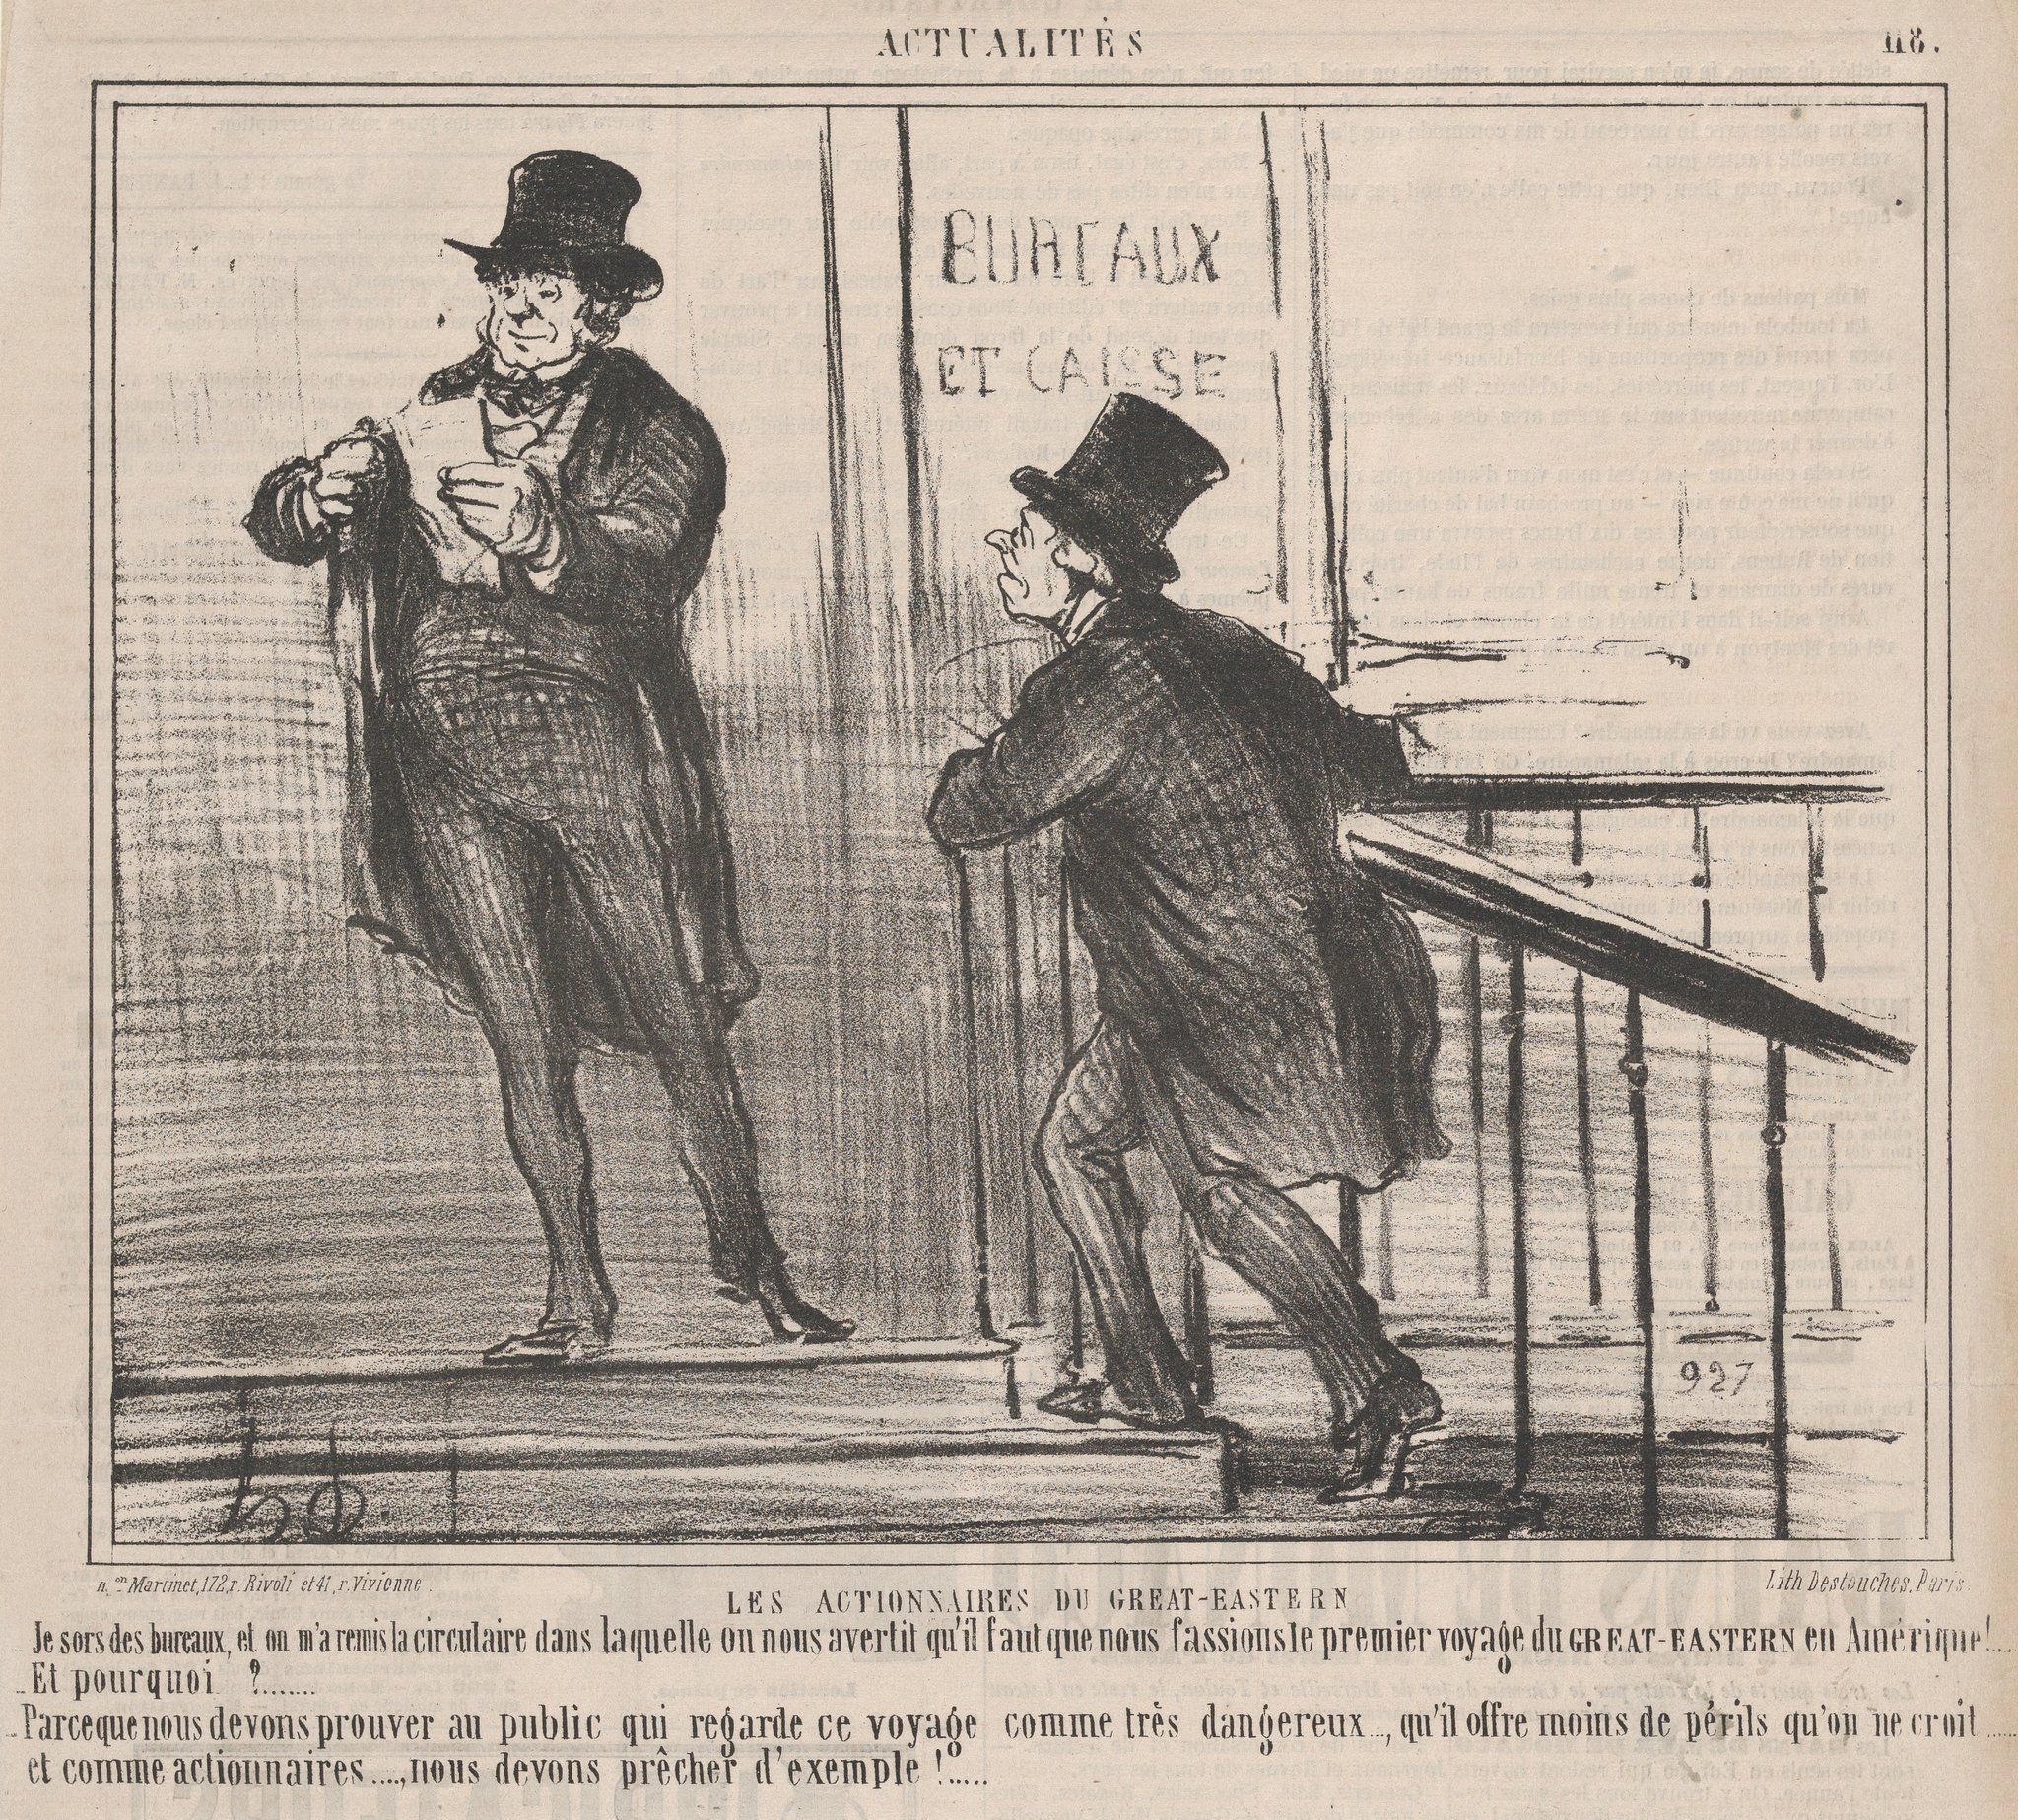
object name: print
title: LES ACTIONNAIRES DU GREAT-EASTERN...., from En Italie, published in Le Charivari, November 21, 1859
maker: honoré daumier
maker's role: artist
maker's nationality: french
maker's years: 1808-1879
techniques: lithograph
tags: men